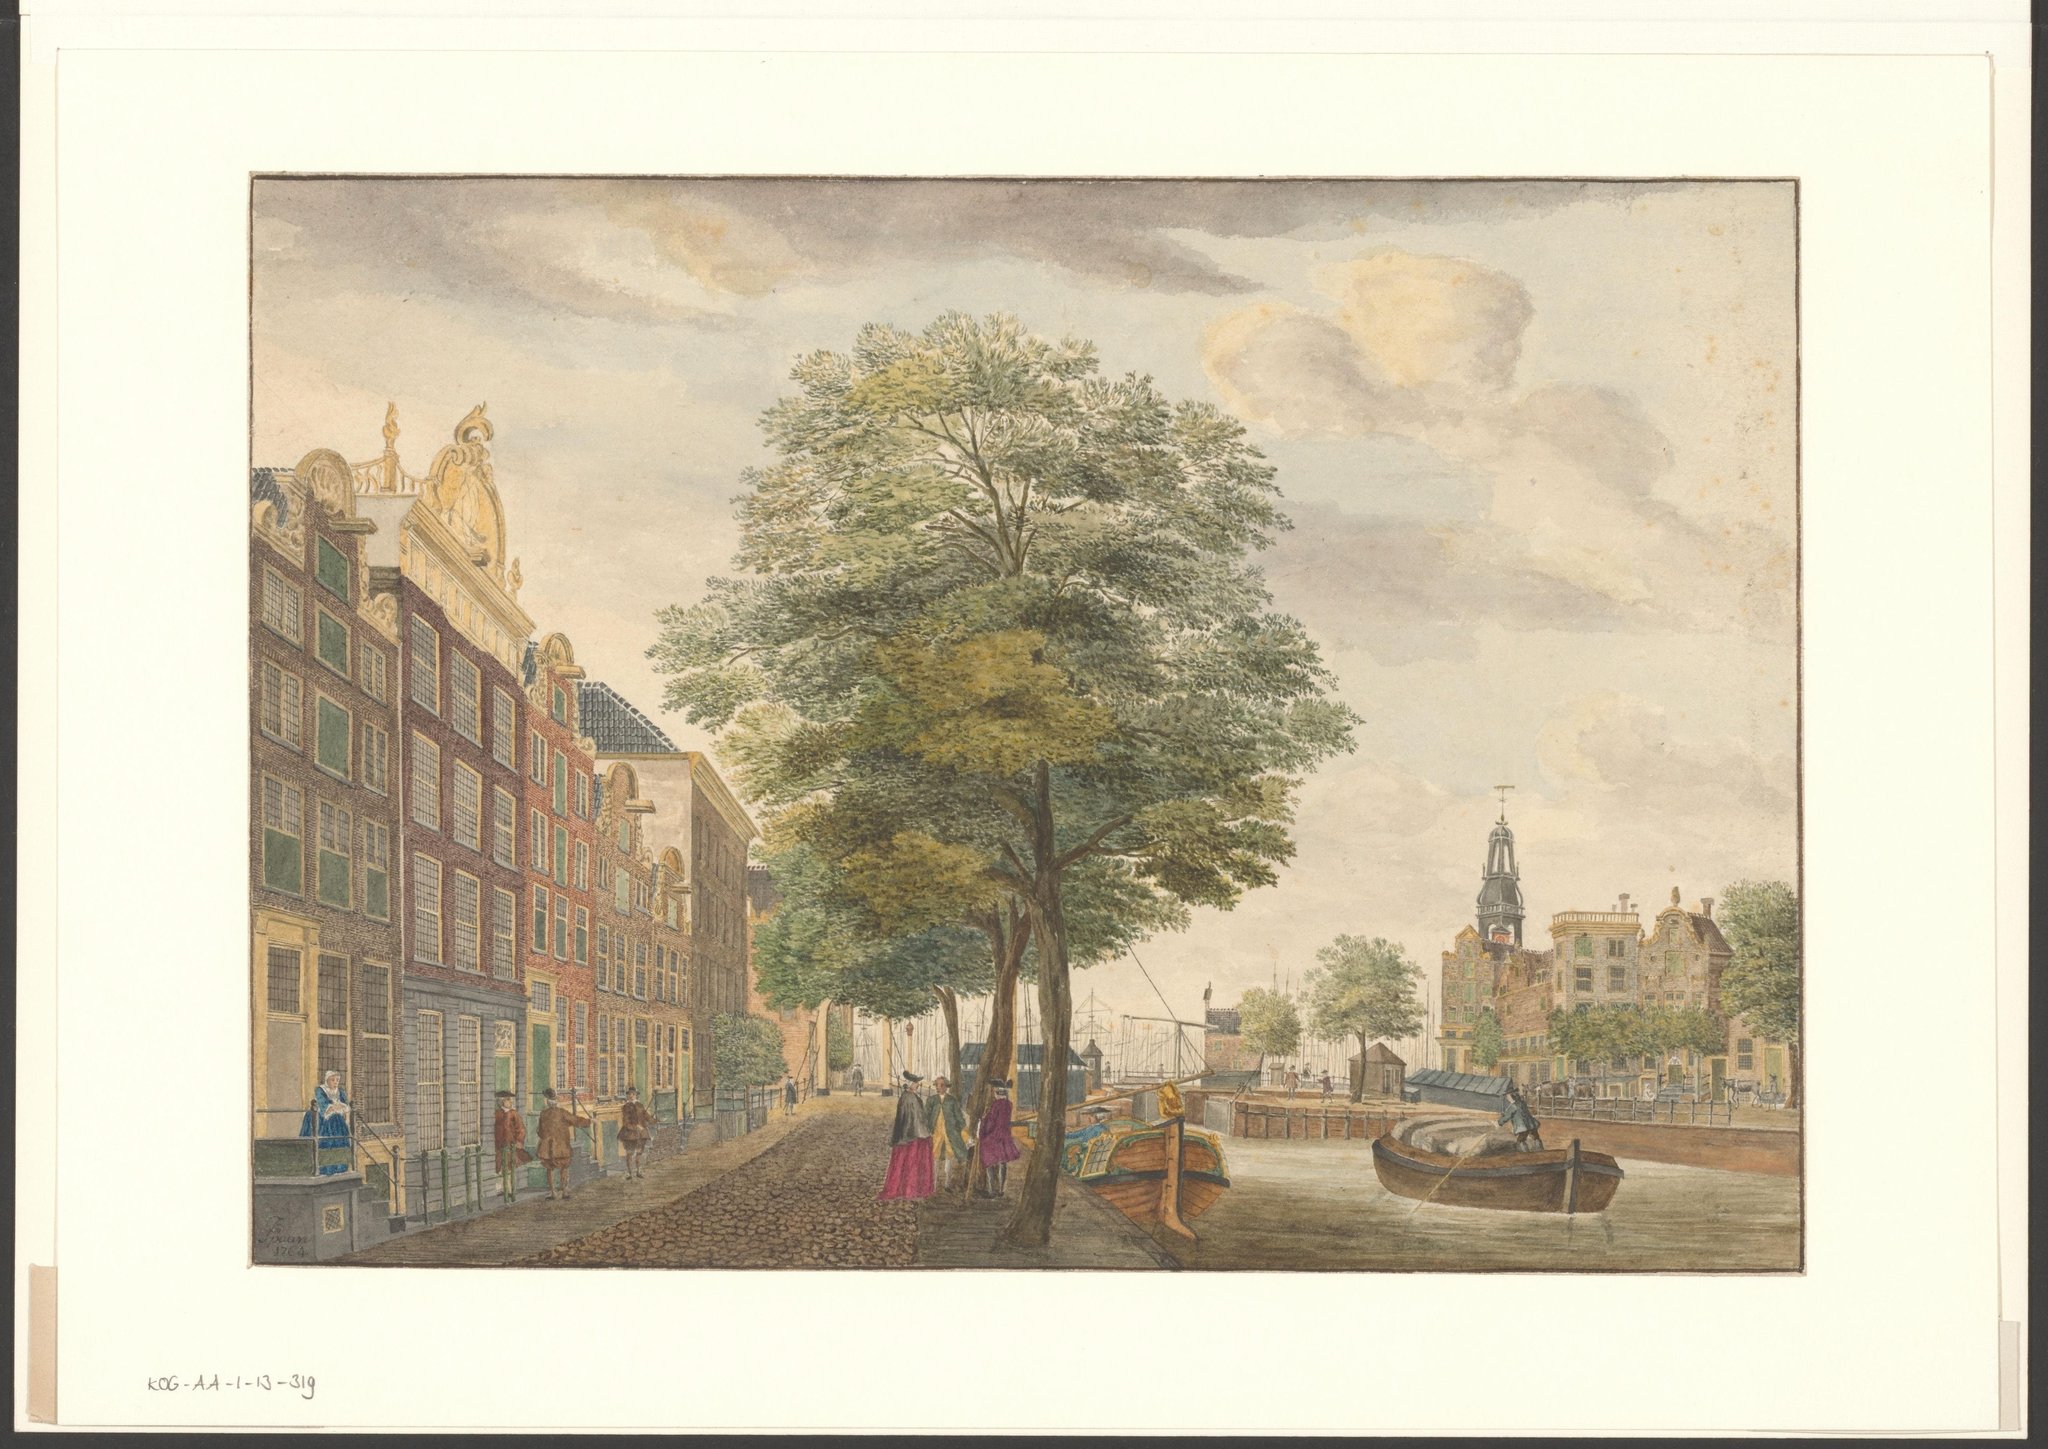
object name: drawing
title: Gezicht op het Singel, hoek Brouwersgracht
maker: jan spaan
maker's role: print maker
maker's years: 1742-1828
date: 1764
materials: ink, paper, pencil, watercolor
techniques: brush, pen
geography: amsterdam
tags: tower, clock tower ~ monumental adornment, city-view in general; 'veduta', canal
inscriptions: collector's mark: ‘13’ Lugt 1641b, signature and date: ‘JSpaan / 1764’, inscription: ‘de Cingel bij de Brouwersgragt’, inscription: ‘Port. 13-319’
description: Onderwerpsrubriek binnen de Atlas Amsterdam: Oude Schans, Schoutensteeg, Singel (Korte), Singel.